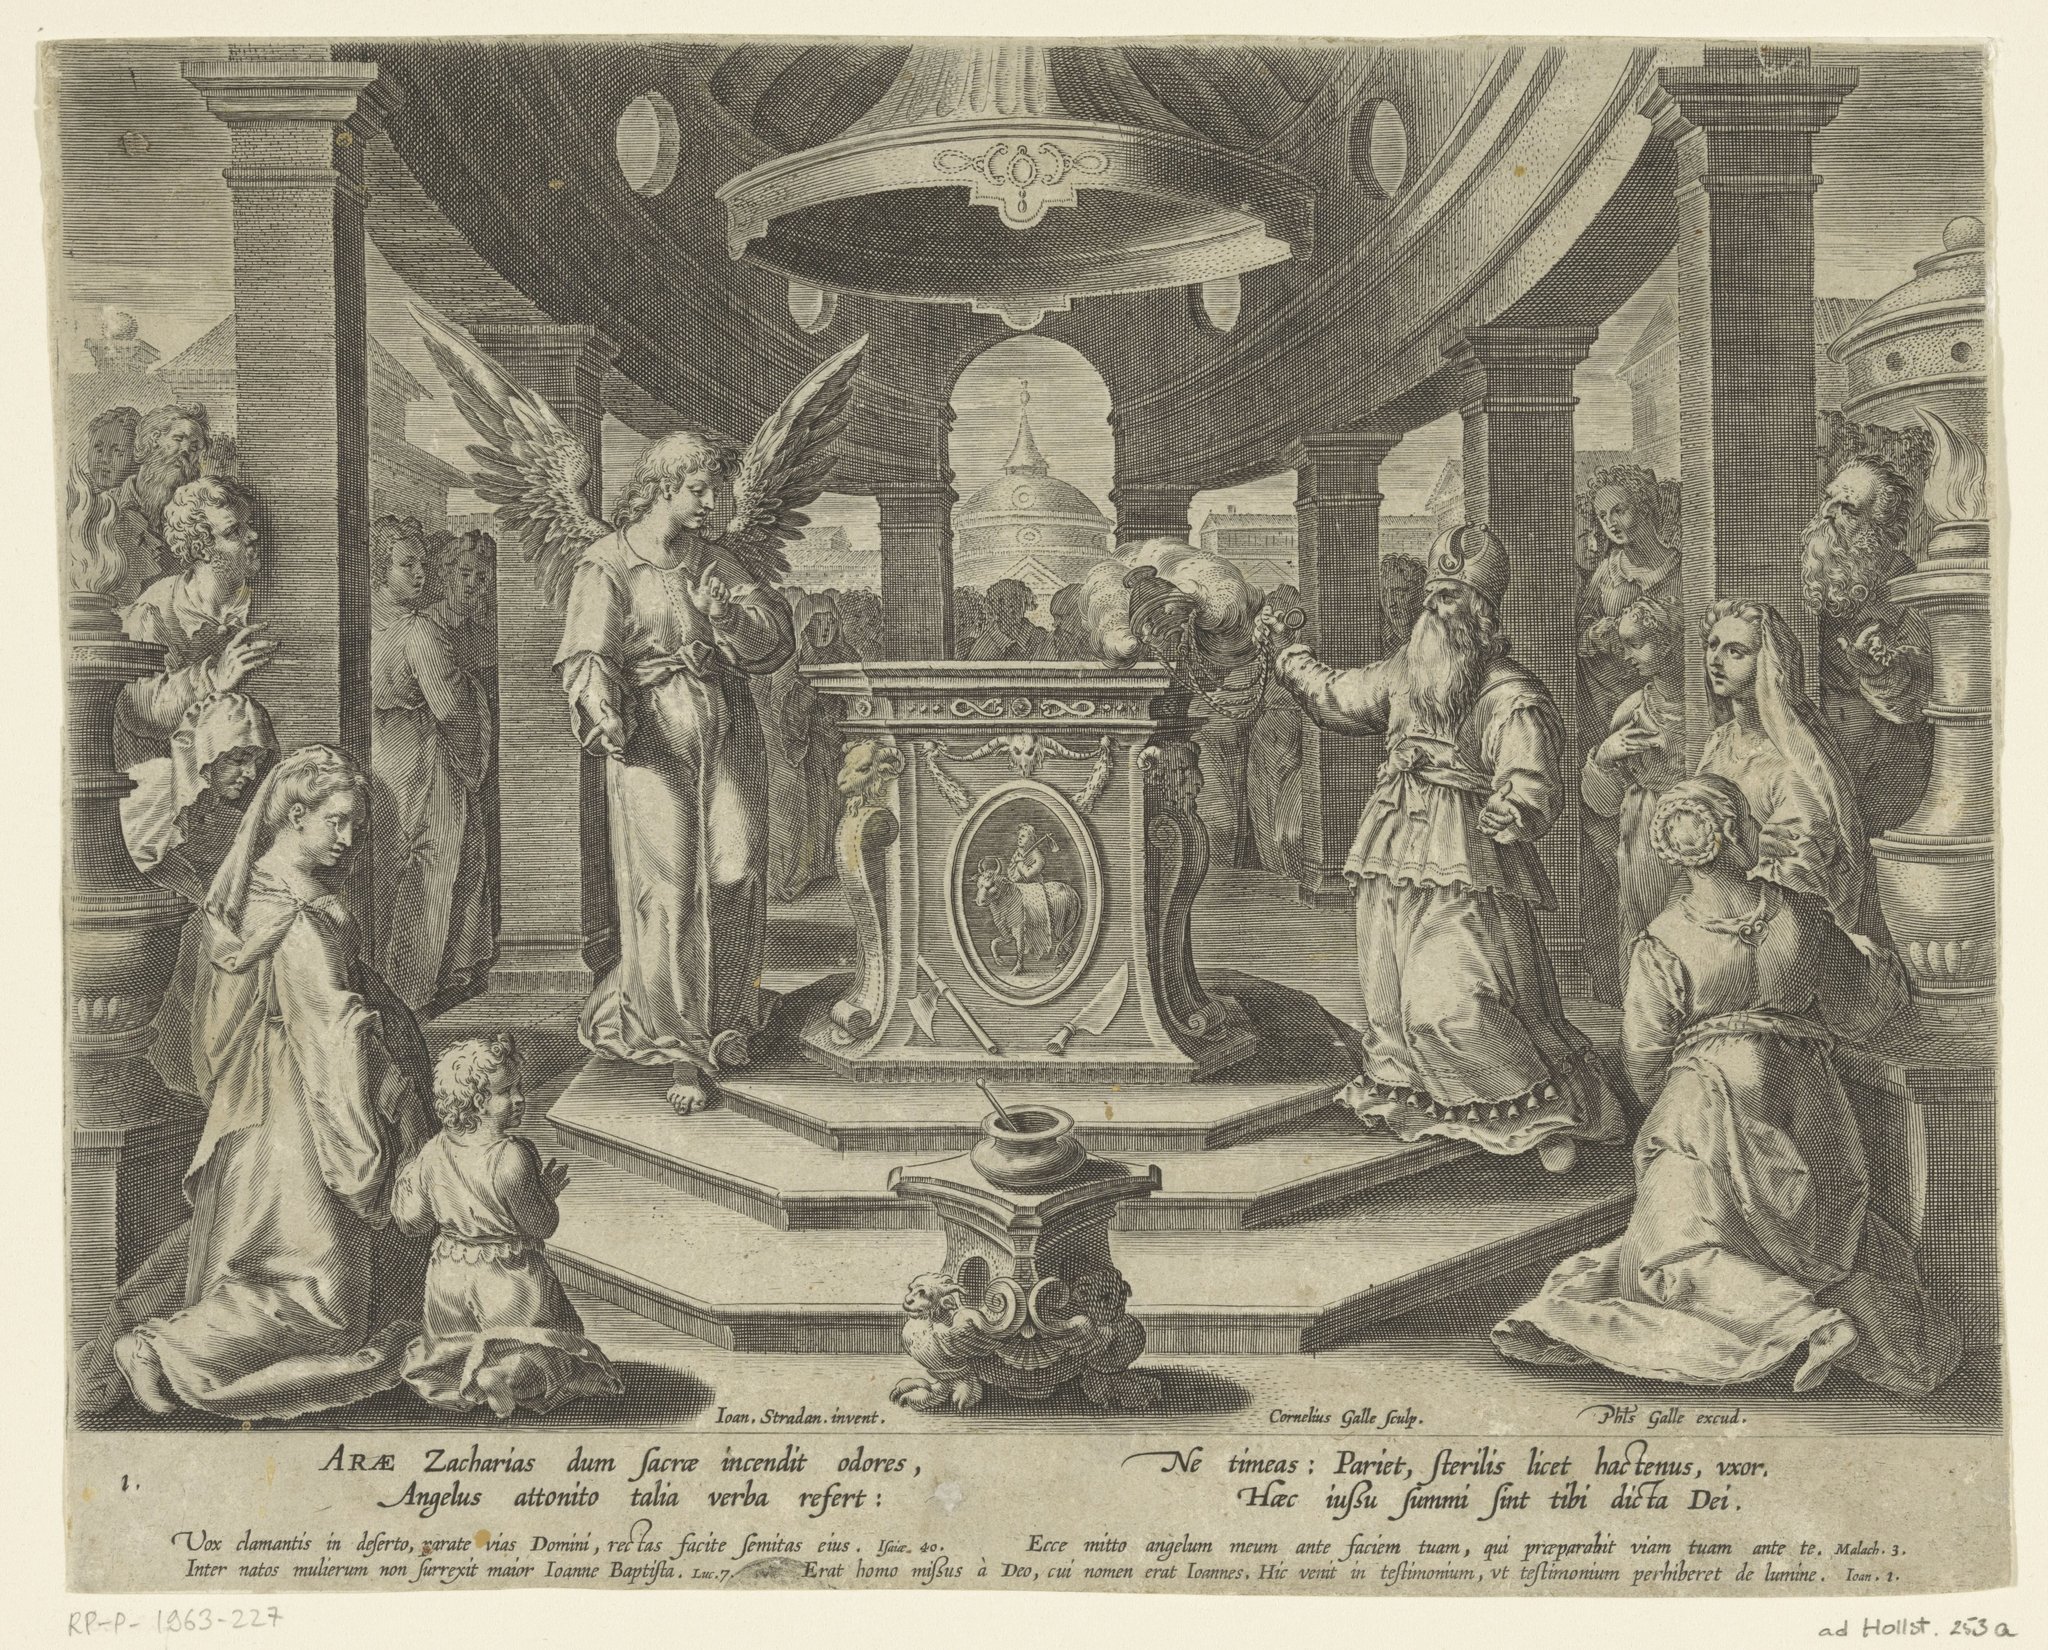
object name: print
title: Het offer van Zacharias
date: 1595-1612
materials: paper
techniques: engraving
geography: antwerp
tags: annunciation of the birth of john the baptist to zacharias: while he is offering incense in the temple an angel (gabriel) appears to him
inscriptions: signature: ‘Ioan. Stradan. invent.’, number: ‘1’, address: ‘Phls Galle excud.’, caption: ‘ARAE Zacharias dum sacrae incendit odores...tibi dicta Dei’, signature: ‘Cornelius Galle sculp.’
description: Gezicht op een altaar in een ronde tempel. Zacharias knielt voor het altaar en zwaait met een wierookvat. Links staat een engel die hem de voorspelling van de geboorte van Johannes de Doper doet. Veel omstanders kijken naar de scène. Onder de voorstelling een vers in het Latijn en citaten uit bijbelboeken.